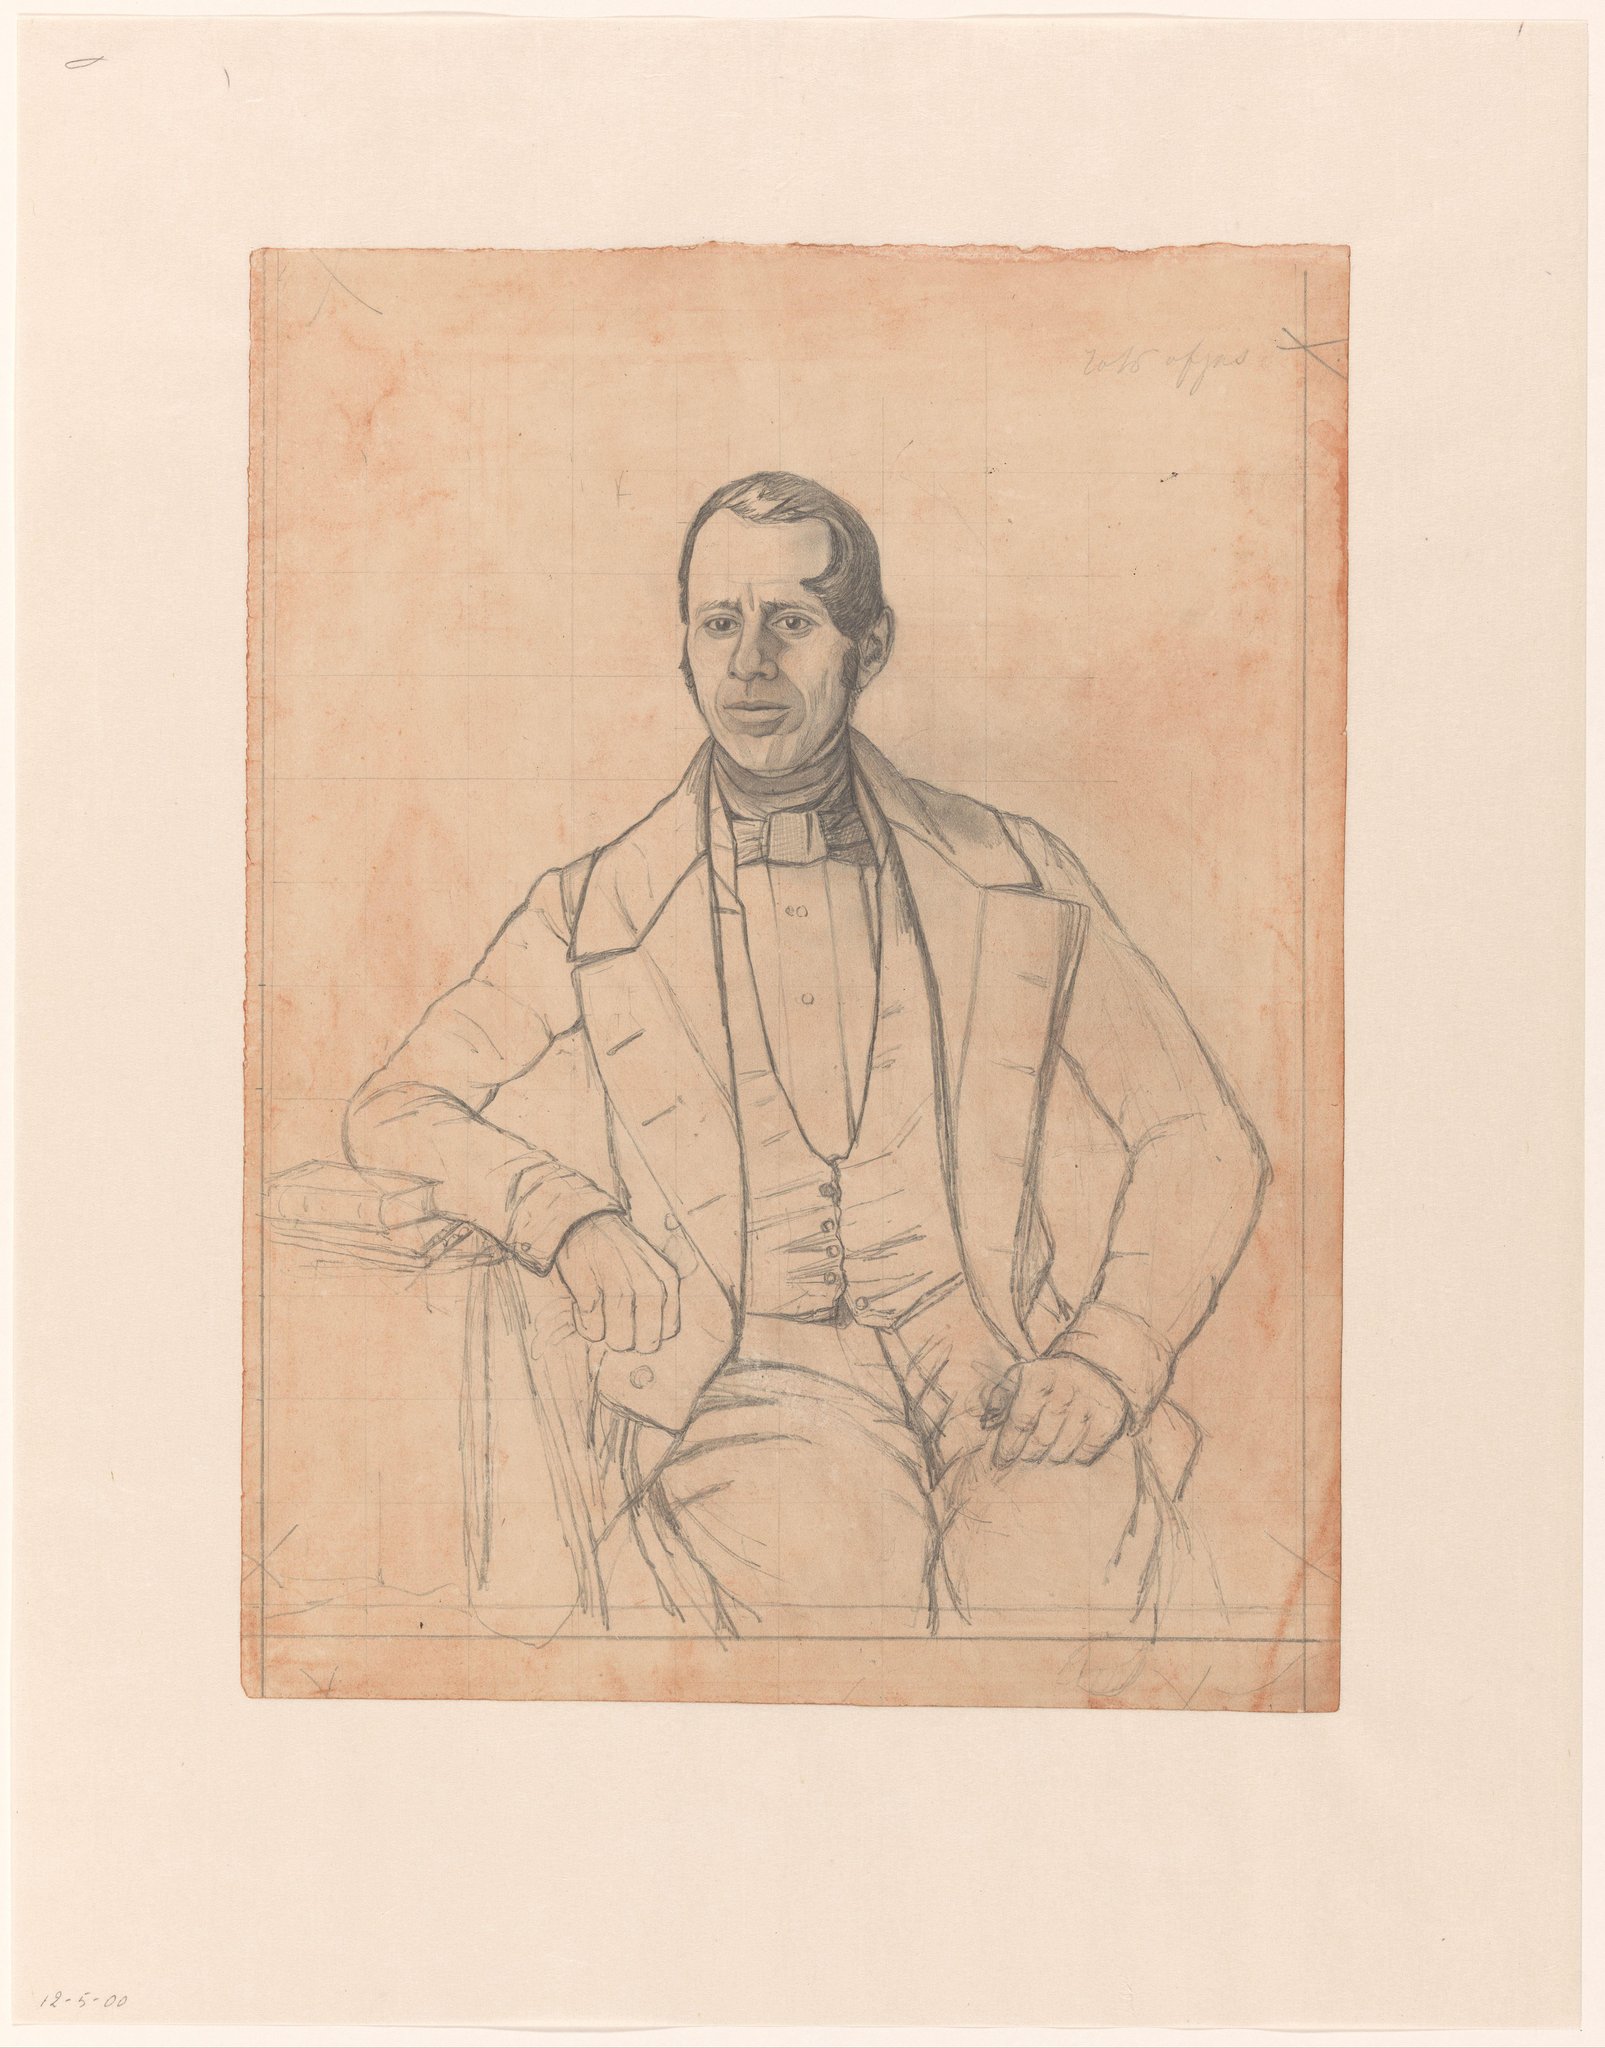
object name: drawing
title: Portret van een onbekende zittende man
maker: frederik hendrik weissenbruch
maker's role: draughtsman, print maker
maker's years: 1828-1887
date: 1838-1887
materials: chalk, paper, pencil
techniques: drawing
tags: historical persons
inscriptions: collector's mark: Lugt 2228